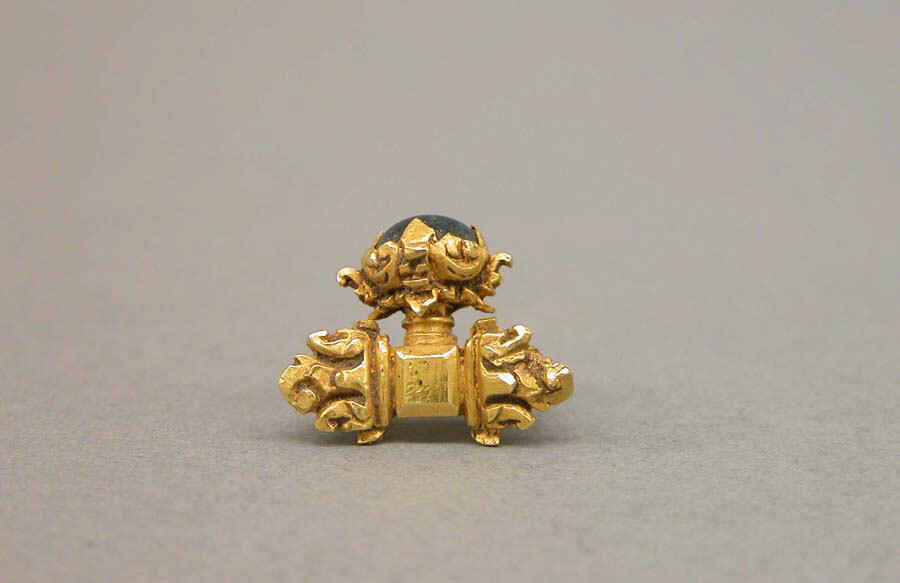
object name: ear clip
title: Ear Clip with Aqua-Green Stone in Foliate Pattern Mount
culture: indonesian, javanese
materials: gold, stone